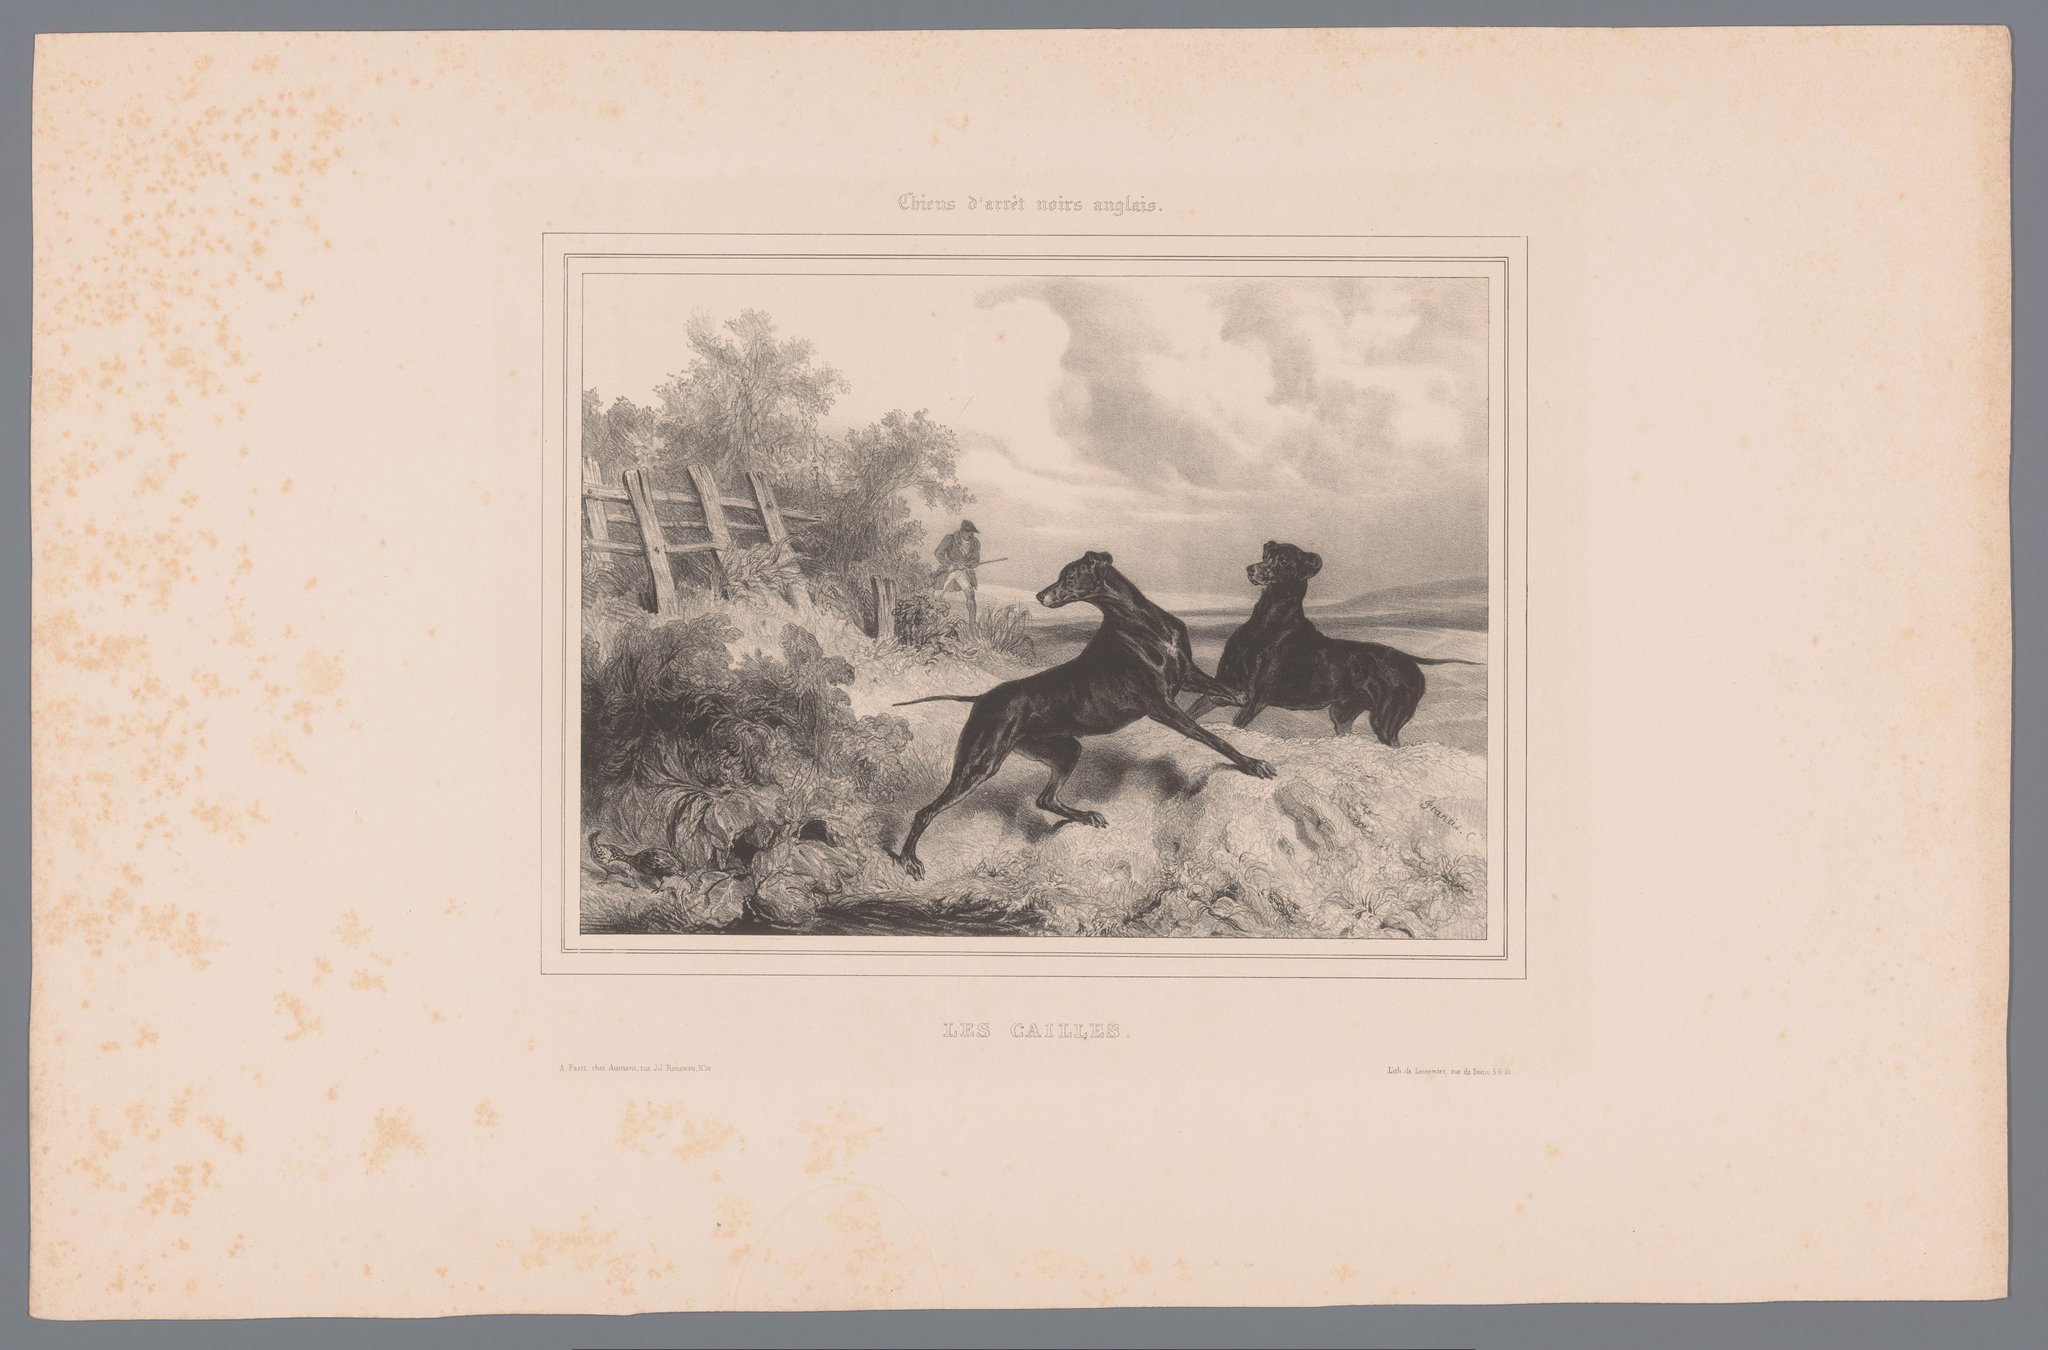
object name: print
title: Twee voorstaande honden hebben een paar kwartels gevonden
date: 1837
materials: paper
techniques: lithograph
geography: paris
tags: hunting dogs, bird hunting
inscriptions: collector's mark: Lugt 2228a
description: Prent maakt deel uit van een omslag met zes prenten.